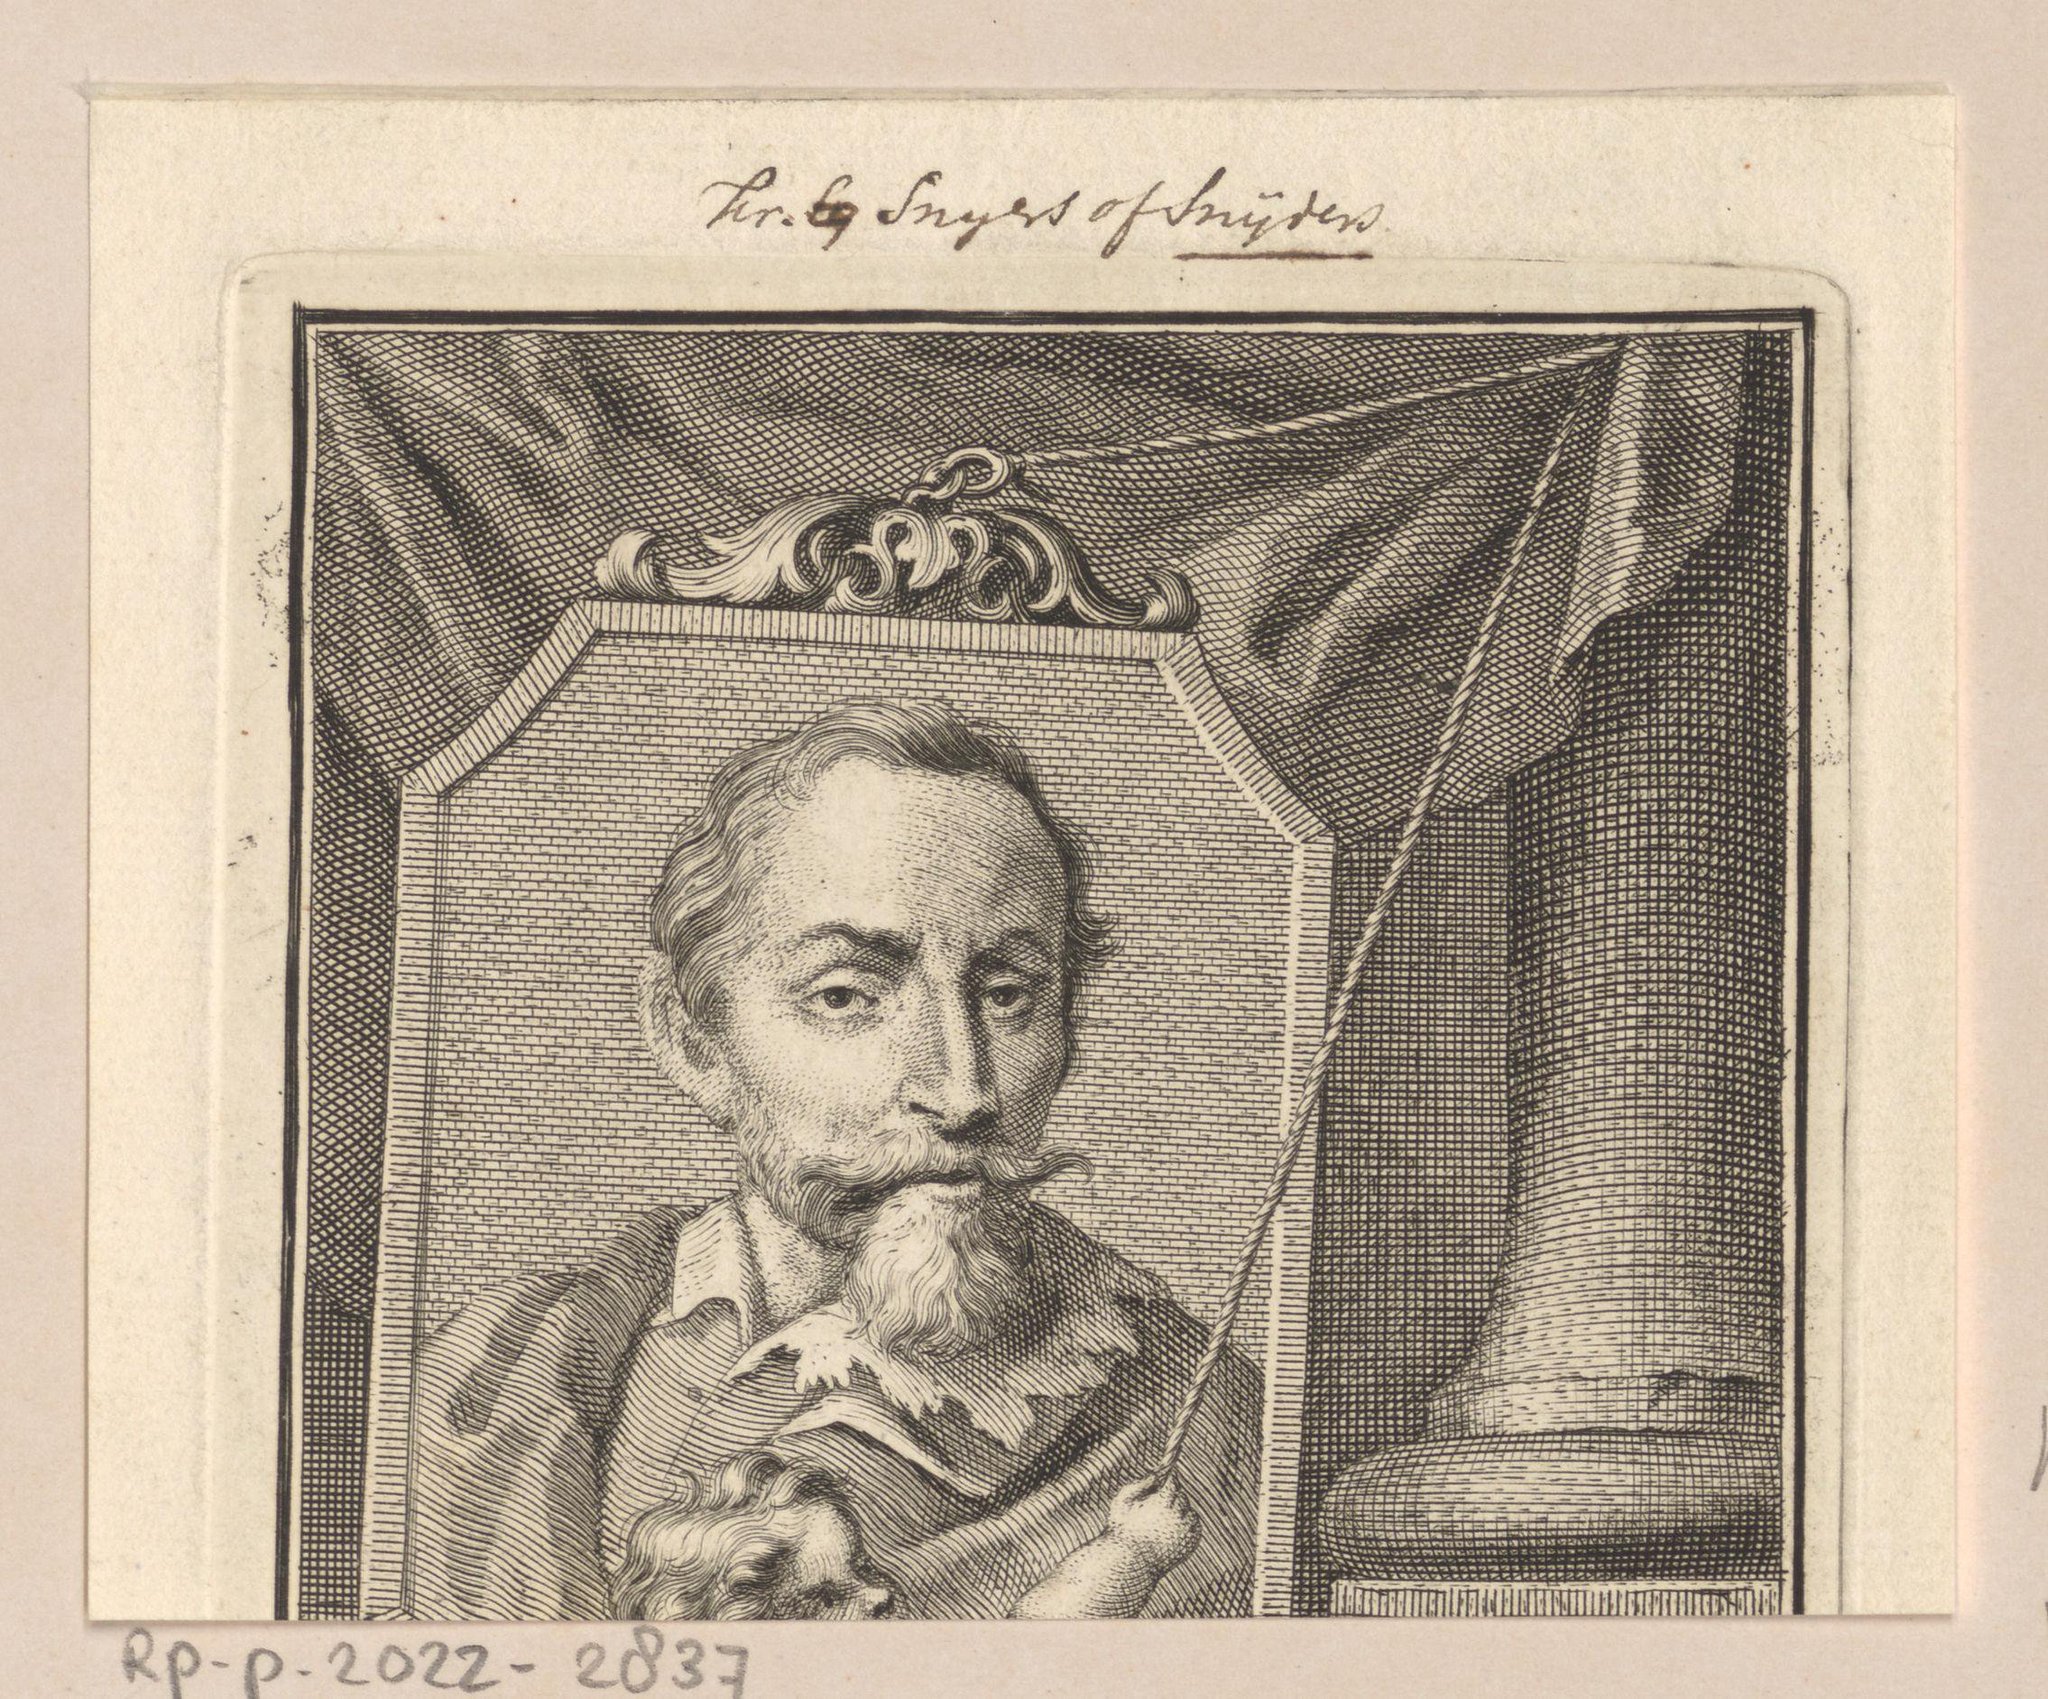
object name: print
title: Portret van Frans Snijders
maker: jacob houbraken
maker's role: draughtsman, print maker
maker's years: 1698-1780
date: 1718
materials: paper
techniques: engraving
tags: antwerp, painter, frans snijders, historical persons, portrait, self-portrait of artist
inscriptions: inscription: ‘Fr. Snyers of Snijders’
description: Prent waarschijnlijk uit: Houbraken, Arnold. De groote schouburgh der Nederlantsche konstschilders en schilderessen. Amsterdam: s.n., 1718.